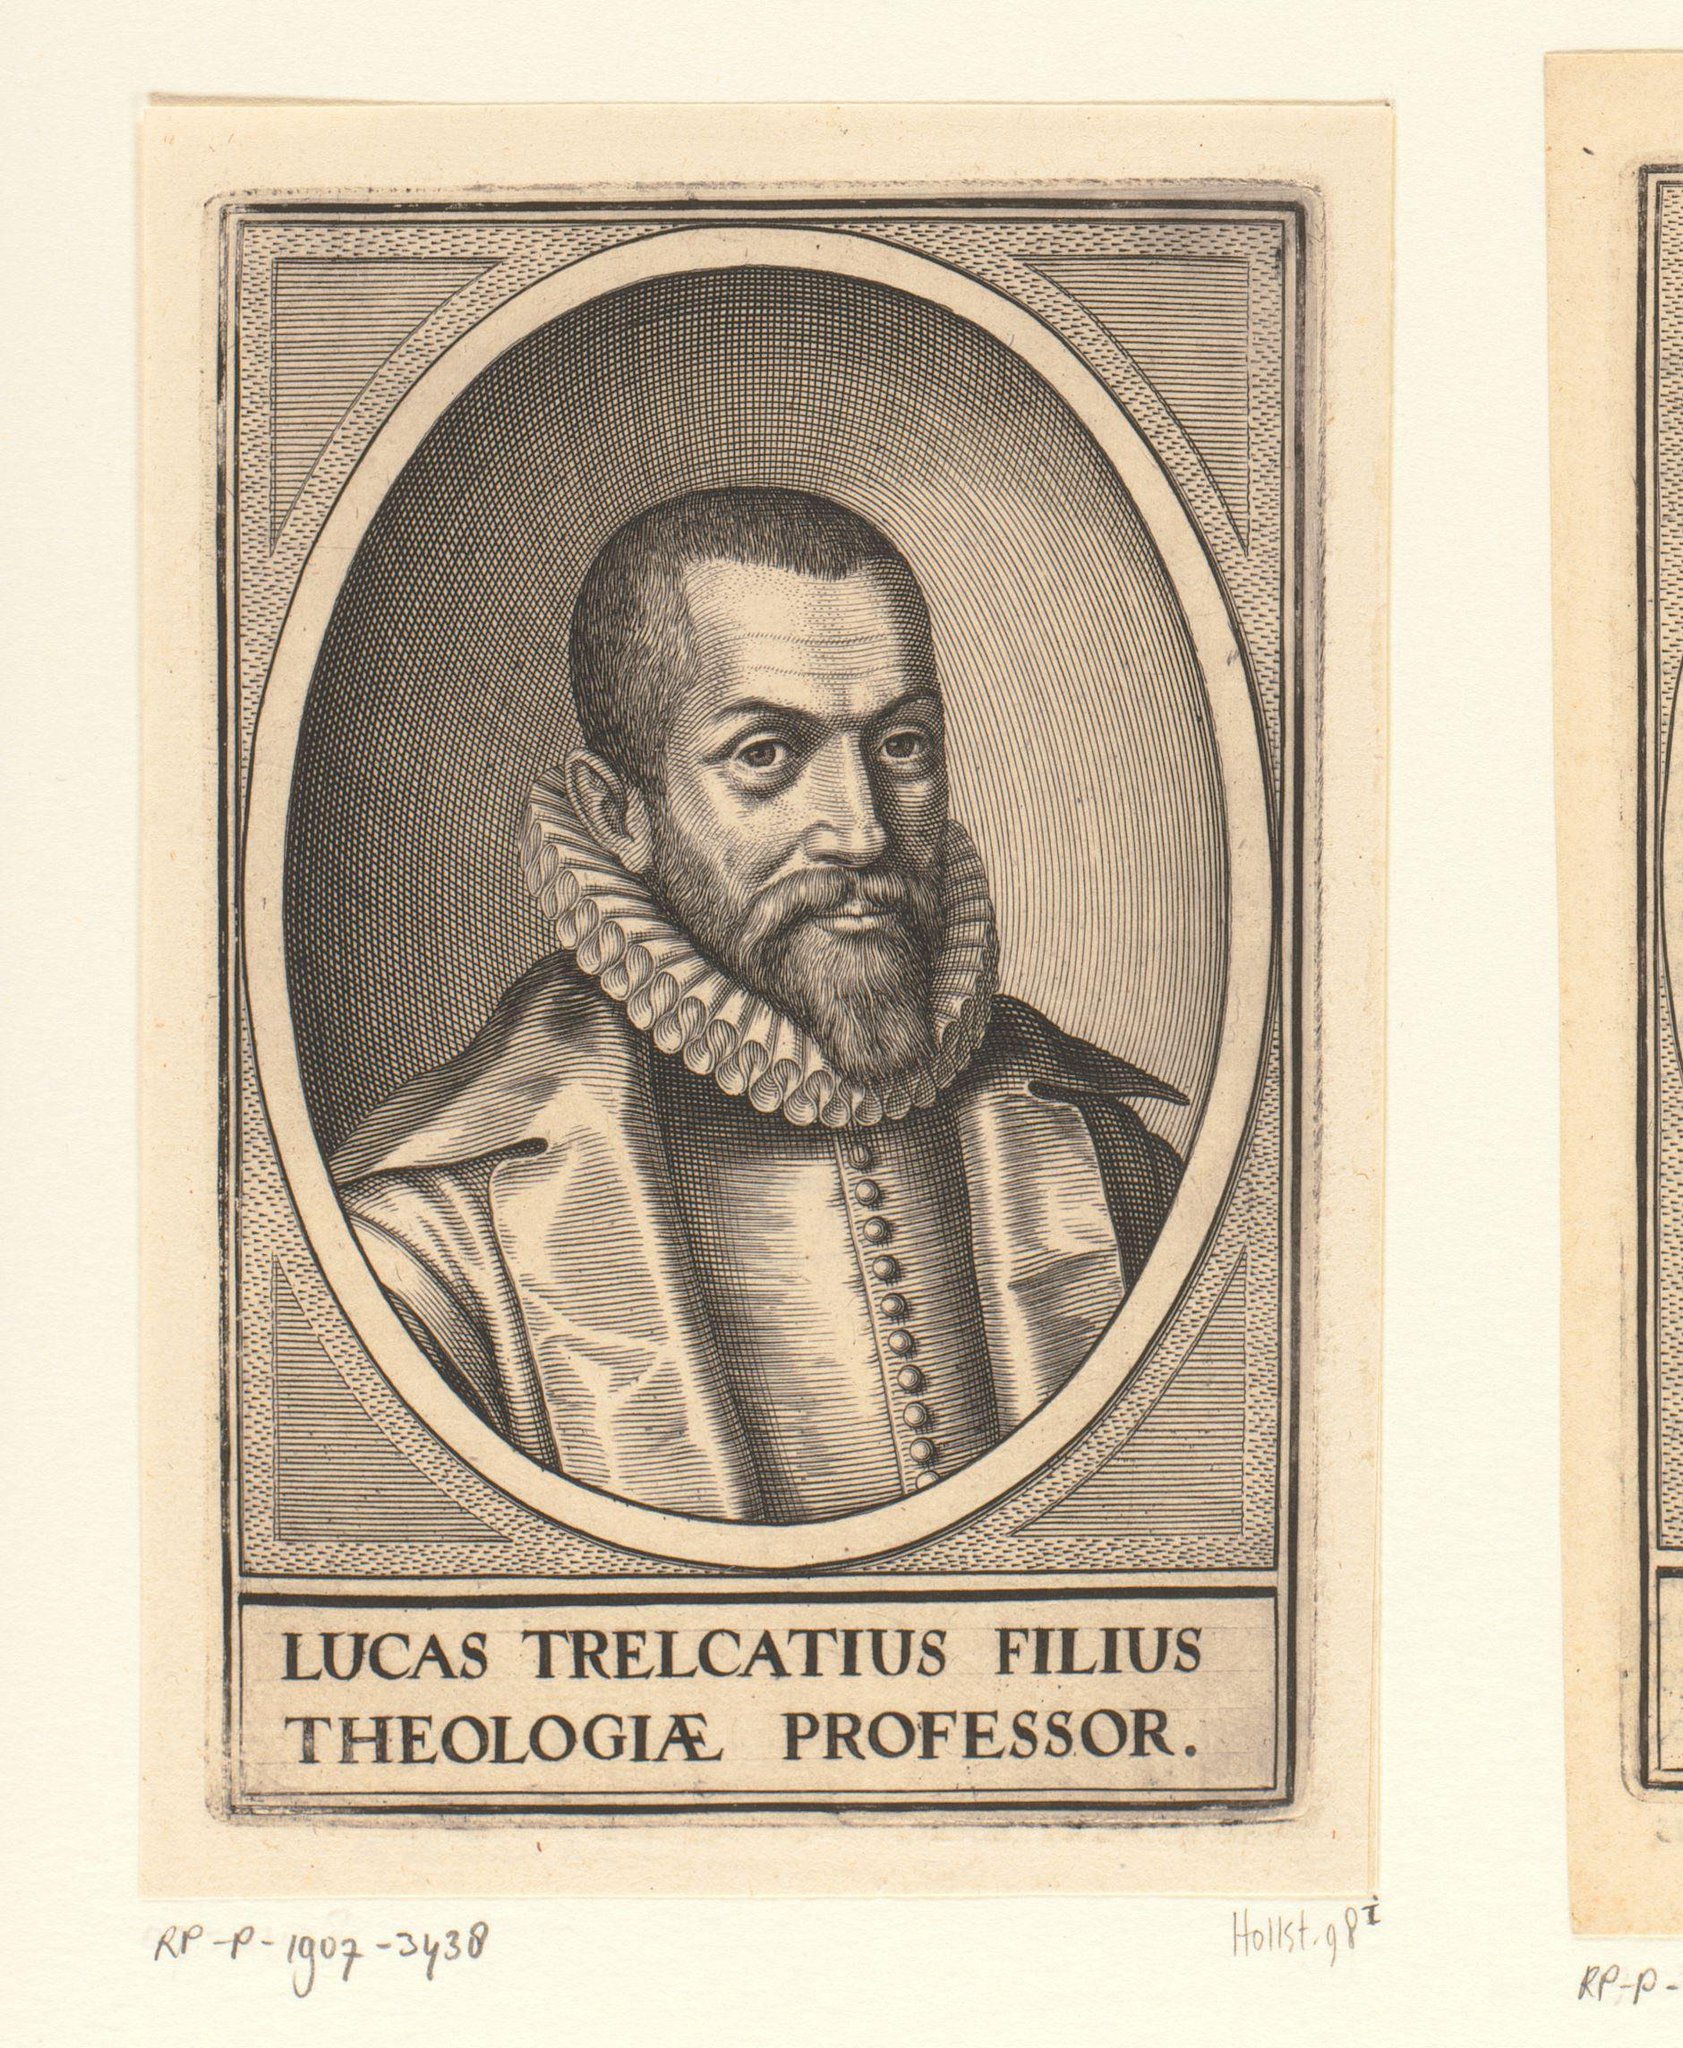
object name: book illustration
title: Portret van Lucas Trelcatius (II)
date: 1609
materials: paper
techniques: engraving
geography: leiden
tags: london, leiden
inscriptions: collector's mark: Lugt 2228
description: Prent uit: Icones ad vivum delineatæ et expressæ, virorvm clariorvm qui præcipue scriptis Academiam Lvgdvno Batavam illustrarunt. Leiden: Andries Clouck, 1609.